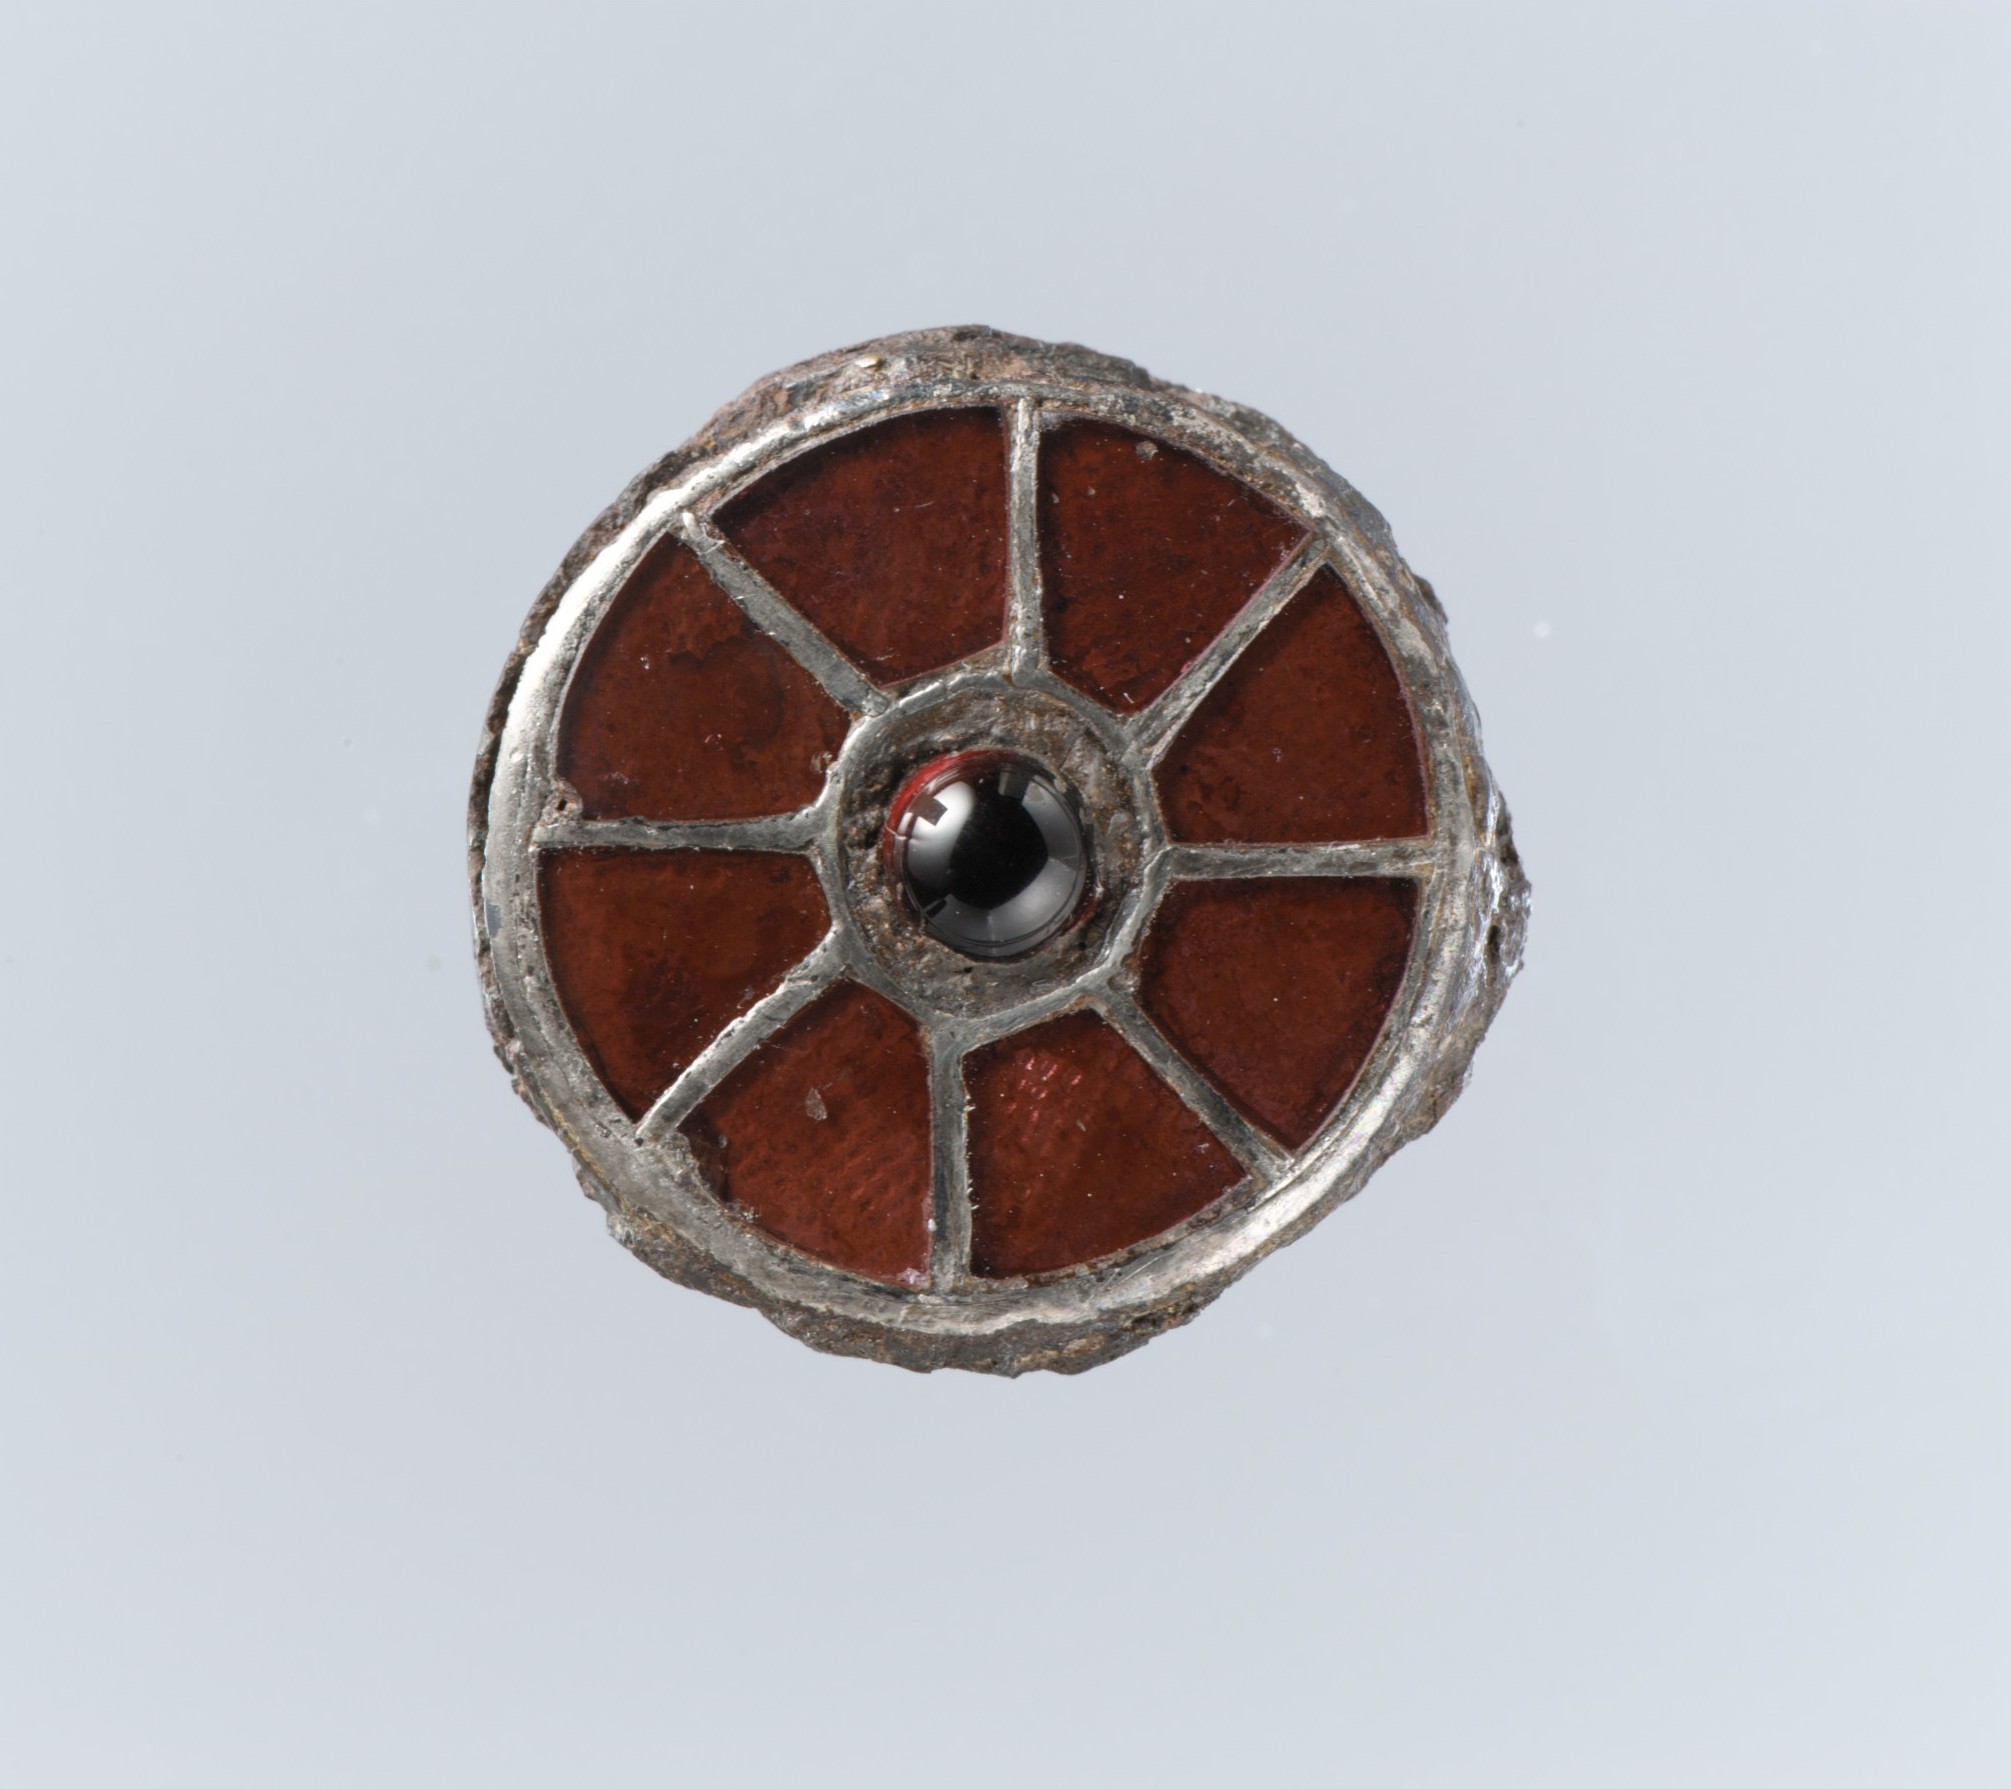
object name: brooch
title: Disk Brooch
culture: frankish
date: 501-600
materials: garnet, silver